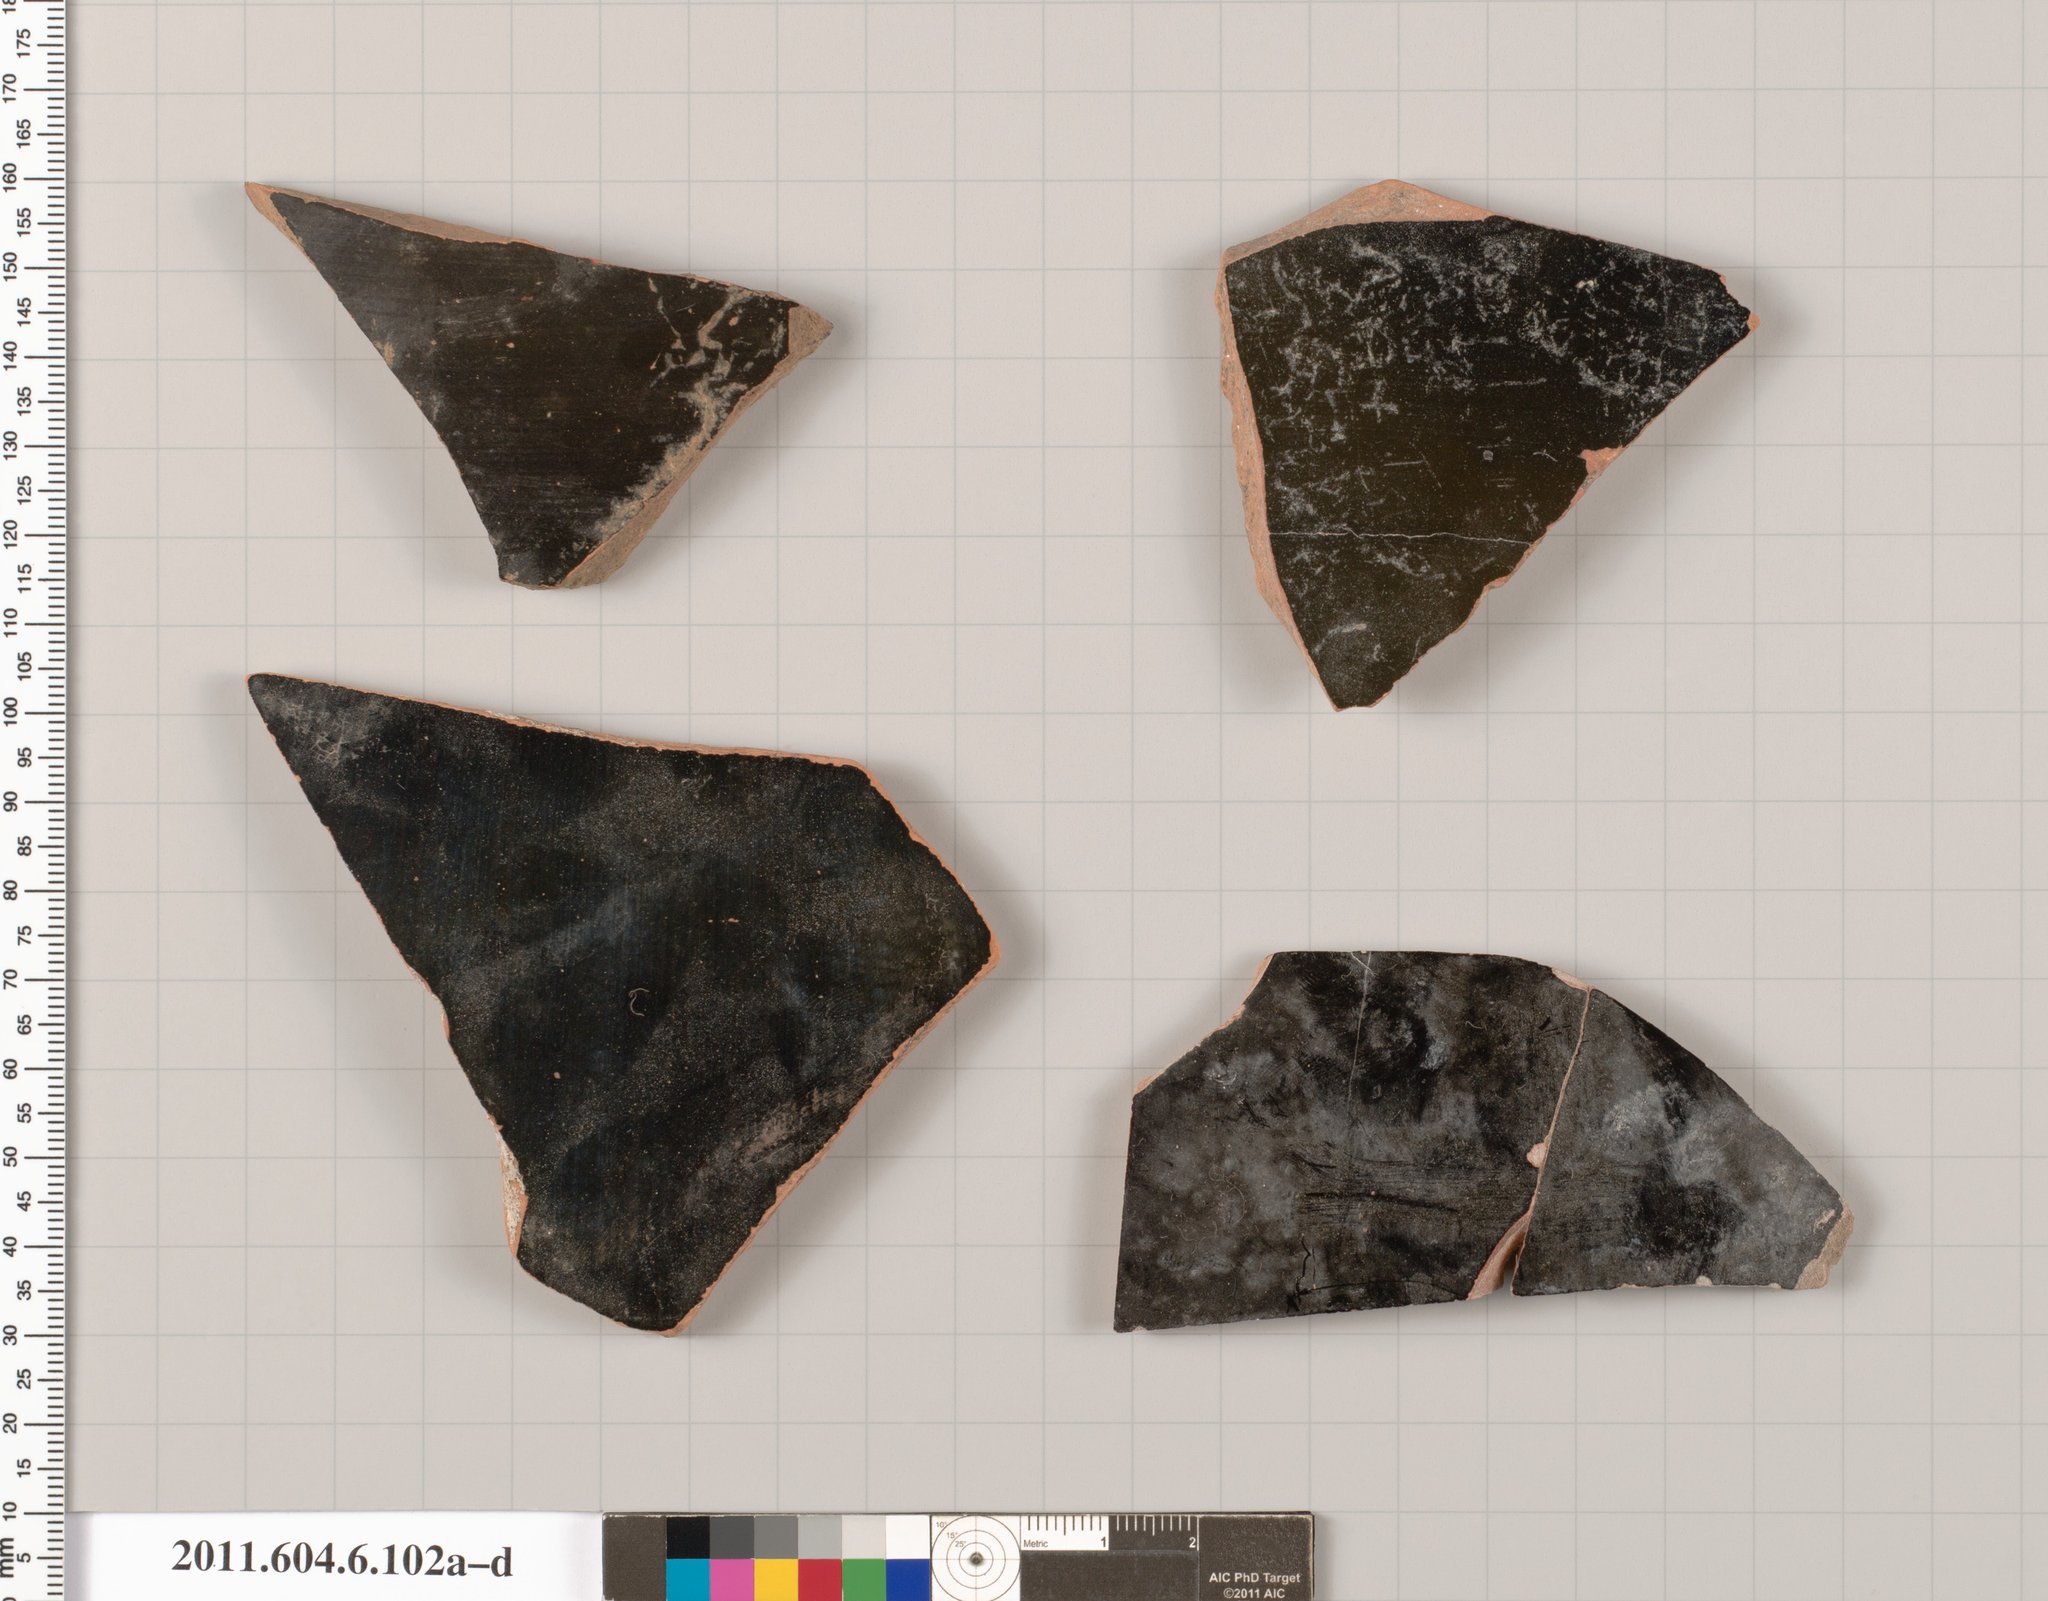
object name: undetermined closed shape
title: Terracotta fragments of closed shapes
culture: greek, attic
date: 600-401 BCE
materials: terracotta